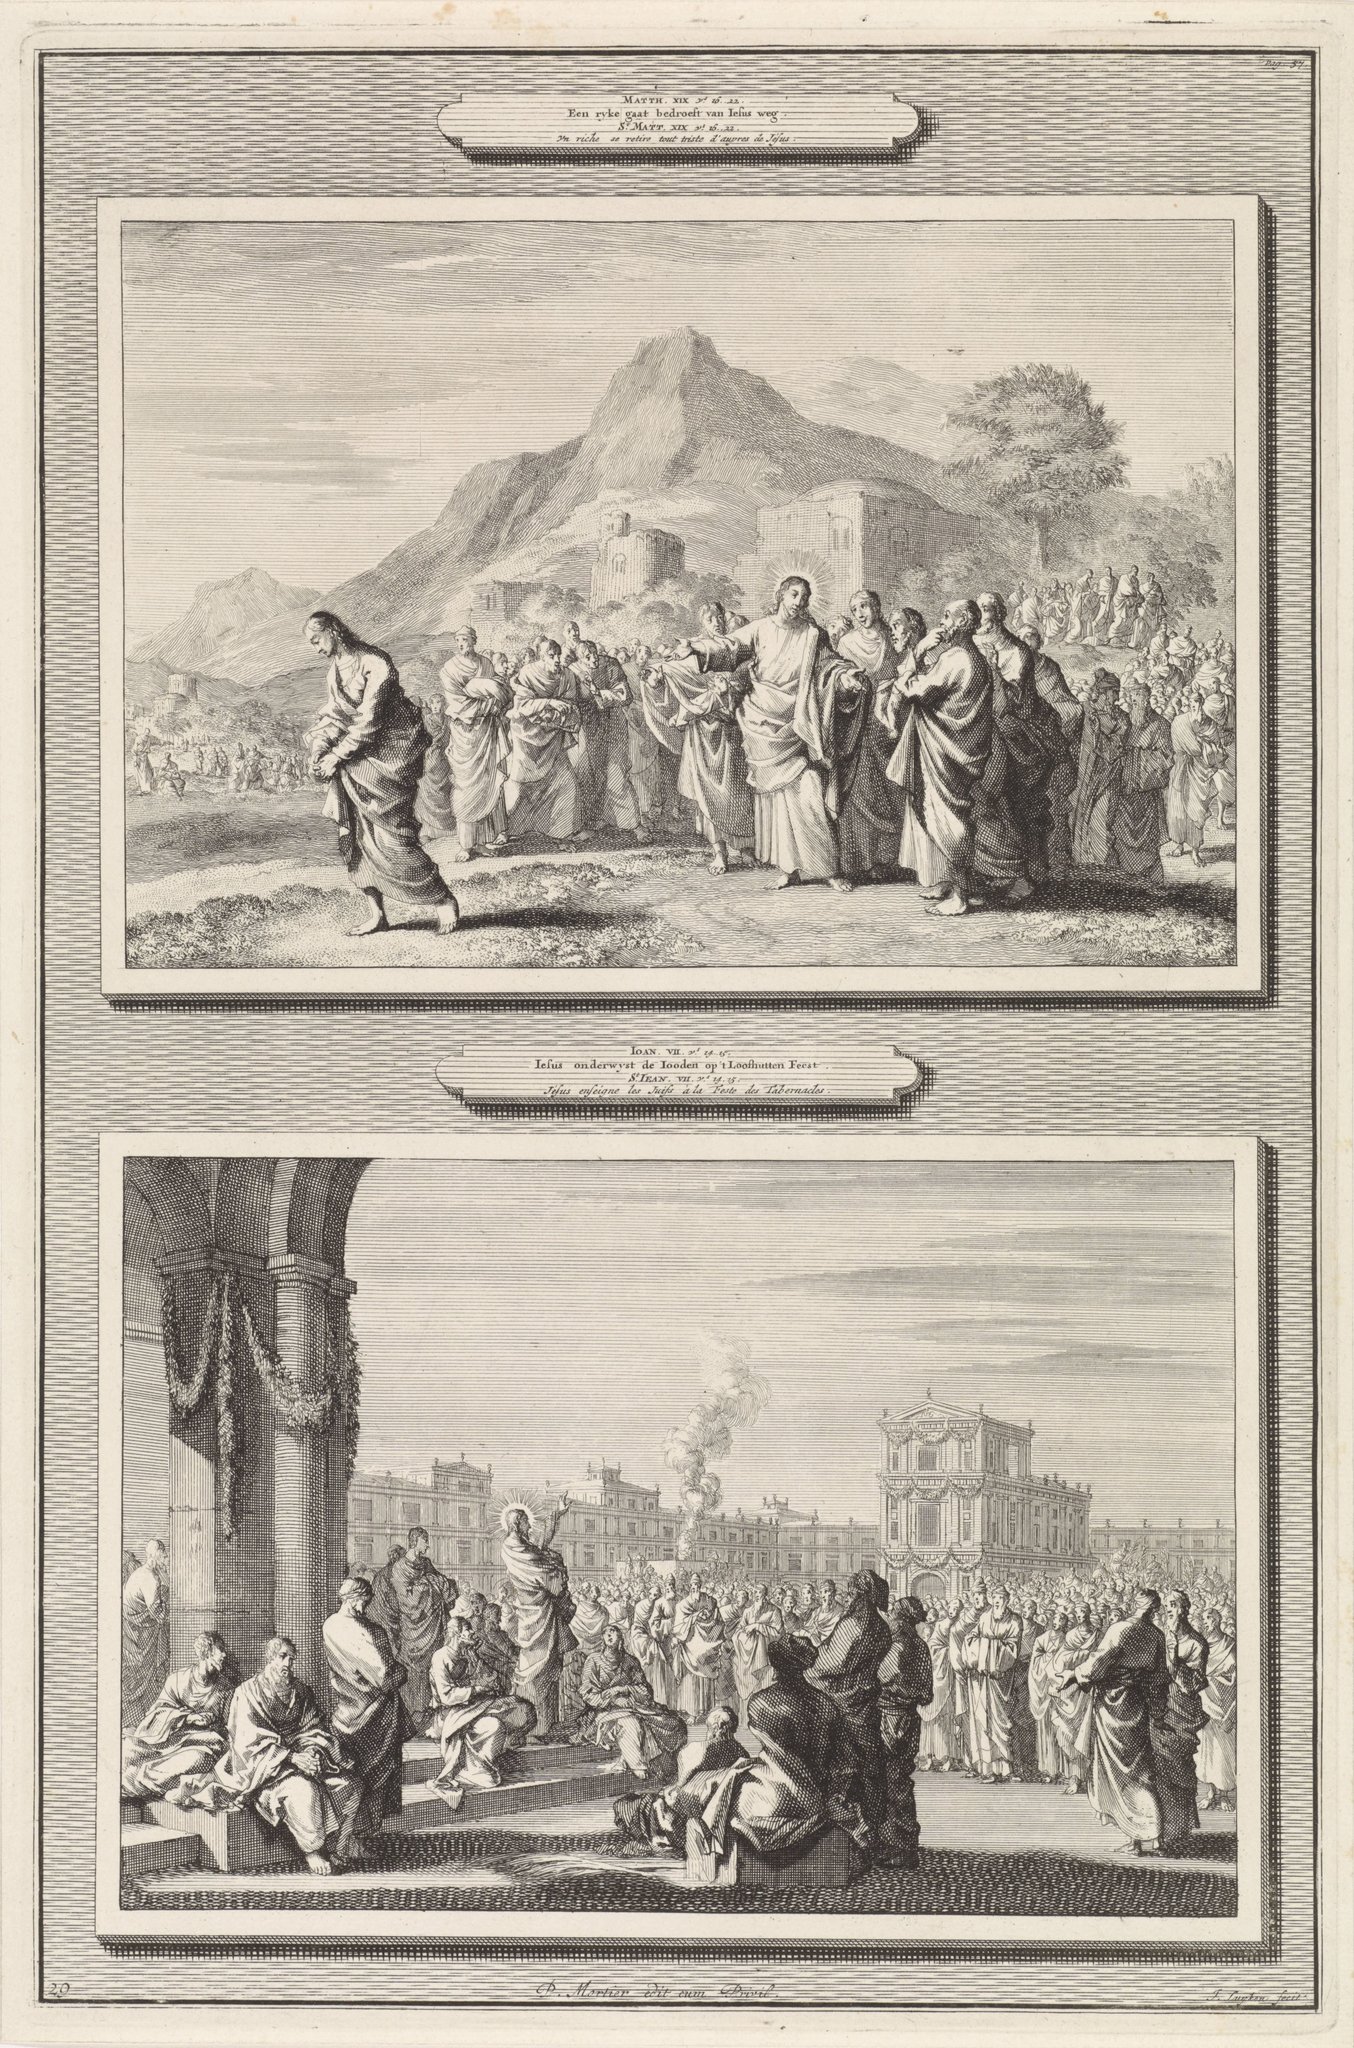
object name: print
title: Christus geeft raad aan een rijke jongeling en de preek van Christus voor de tempel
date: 1700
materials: paper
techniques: etching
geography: amsterdam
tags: christ is teaching in the temple in the middle of the feast of tabernacles, a rich young man who came to see christ goes away sorrowful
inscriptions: collector's mark: Lugt 2228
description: Twee voorstellingen op een plaat. Boven: een rijke jongeling gaat bedrukt weg na het horen van Christus' raadgeving dat hij al zijn bezittingen moet weggeven. Onder: tijdens het loofhuttenfeest staat Christus op de trappen voor de tempel en begint te preken. Hij heeft vele toehoorders.